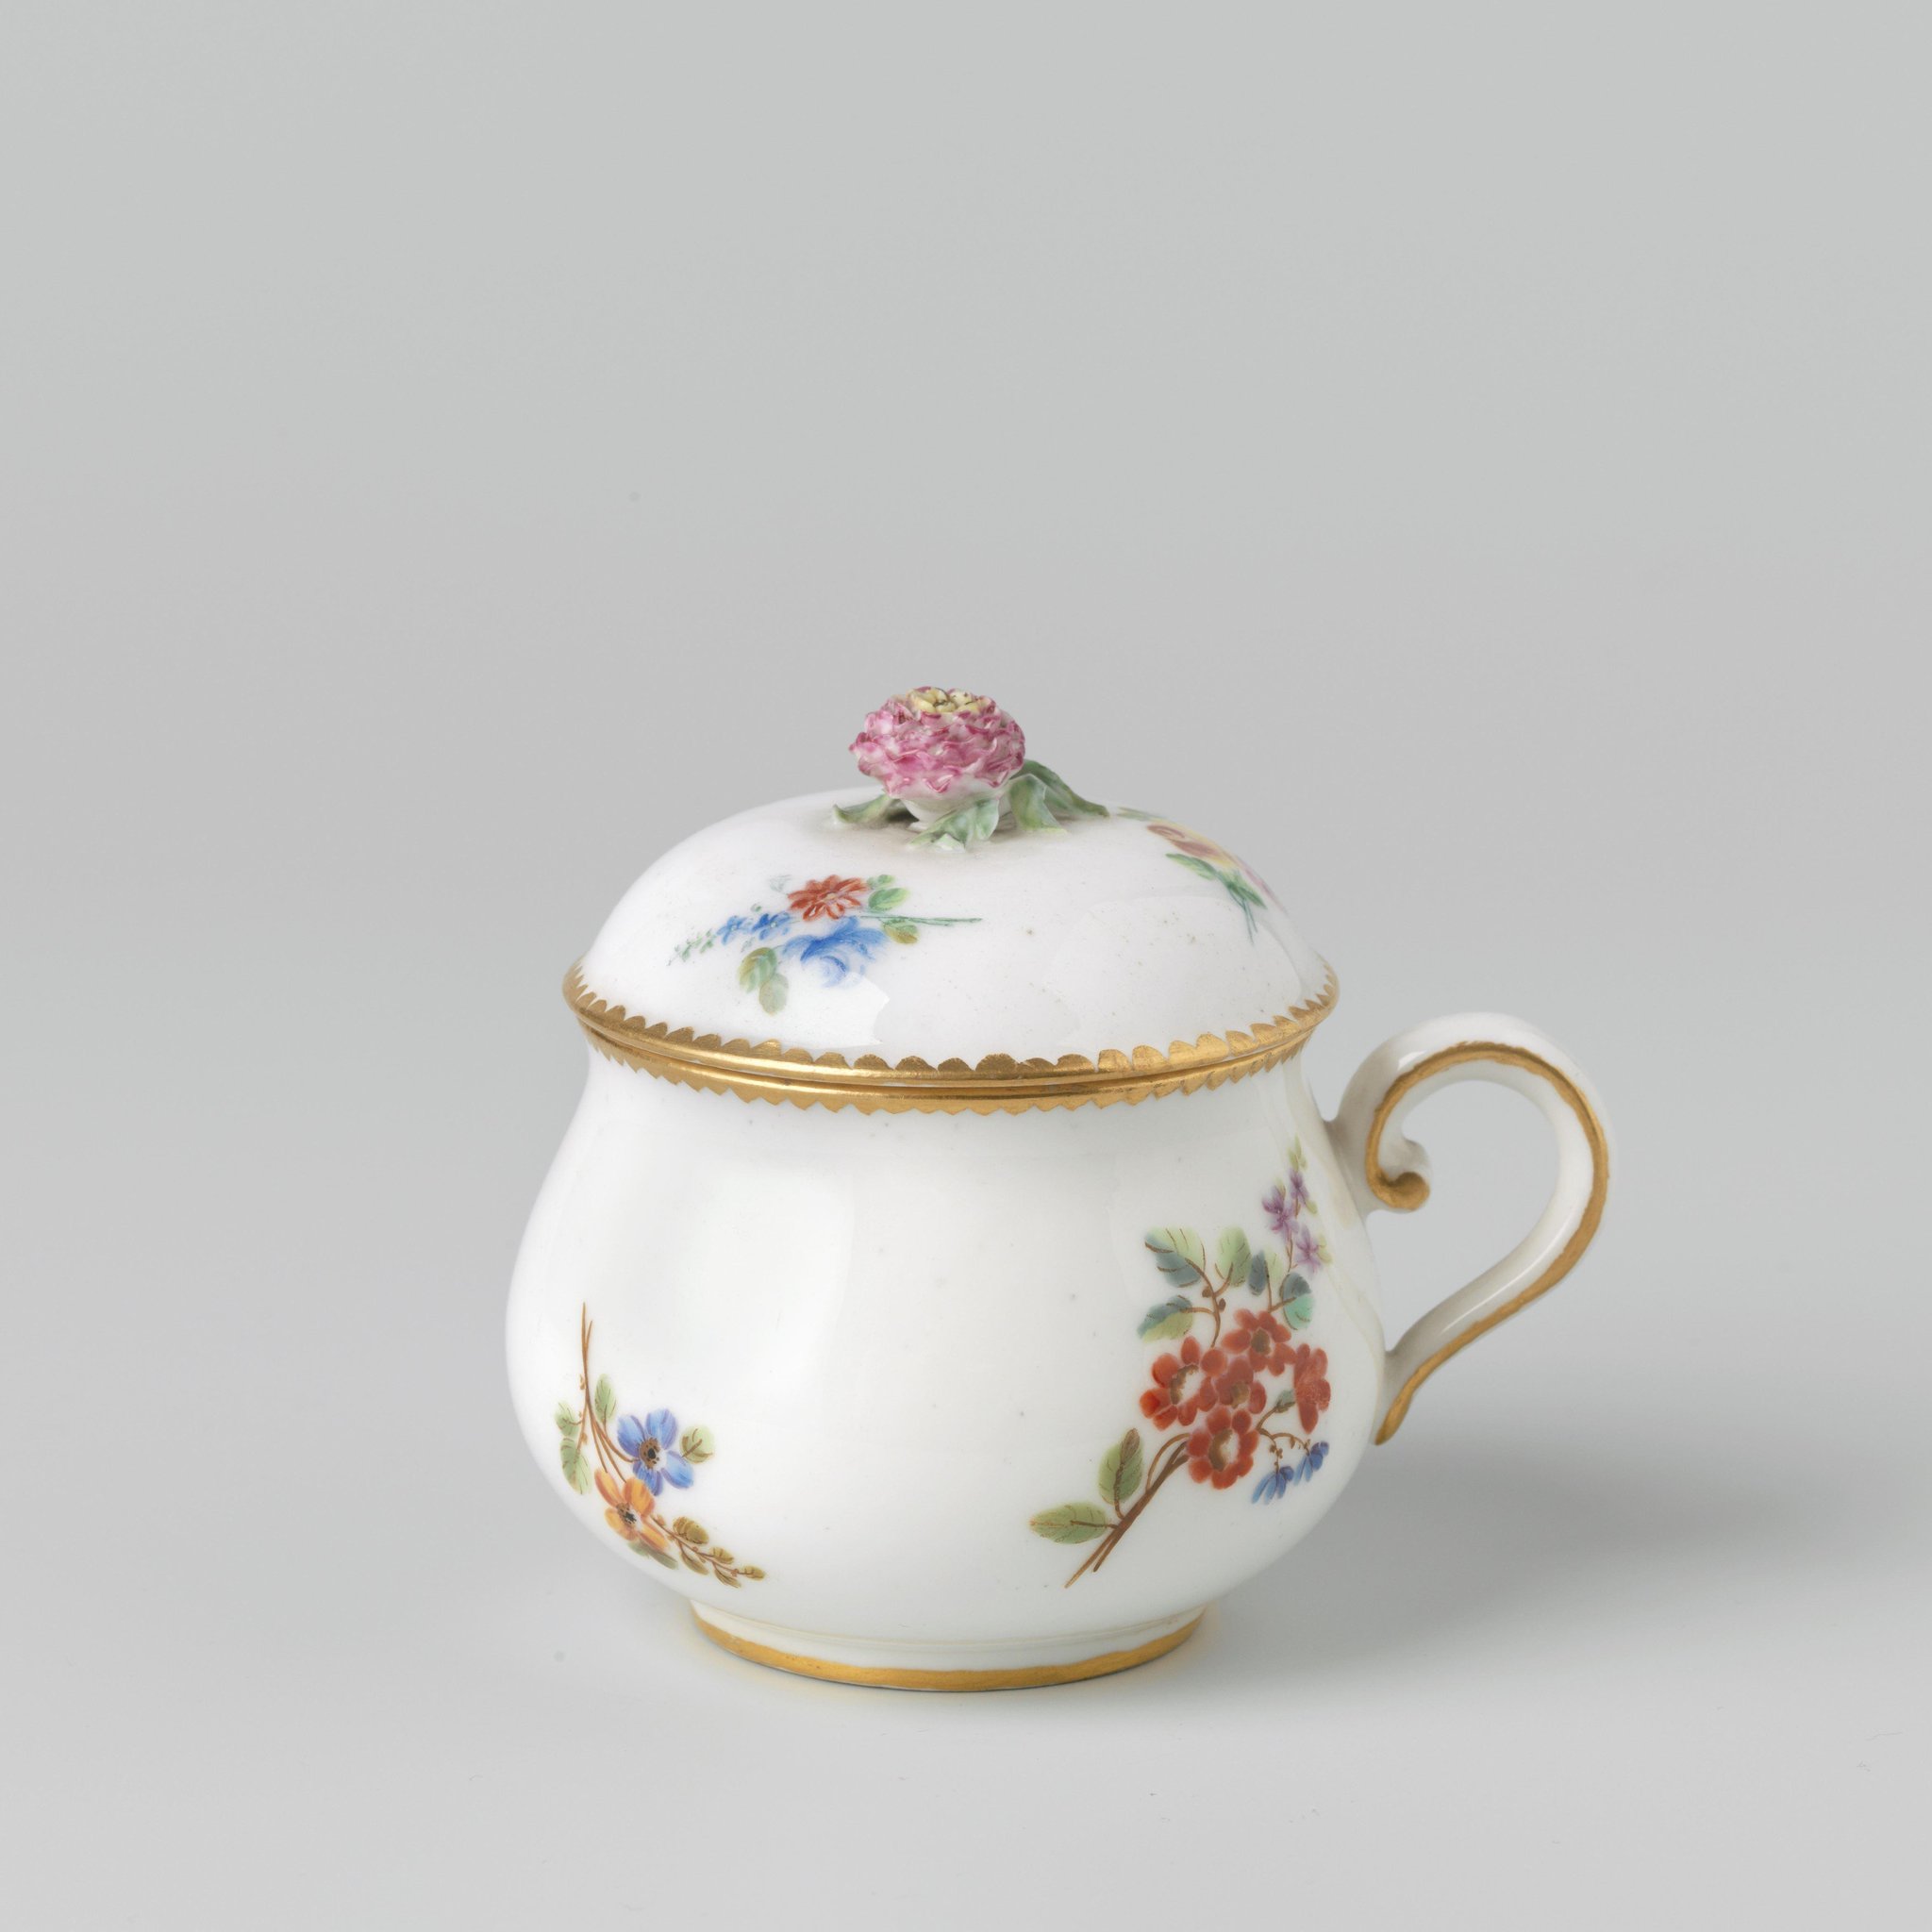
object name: lid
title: Cover of a pot with bouquets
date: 1759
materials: glaze, gold, paint, porcelain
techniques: firing, forming, gilding, turning, vitrification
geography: sèvres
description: Deksel van een pot van porselein, beschilderd op het glazuur in blauw, rood, roze, groen, geel, paars, zwart en goud. Versierd met verschillende boeketten en een decoratieve band in goud op de rand. Dekselknop in de vorm van een bloem (chrysant).